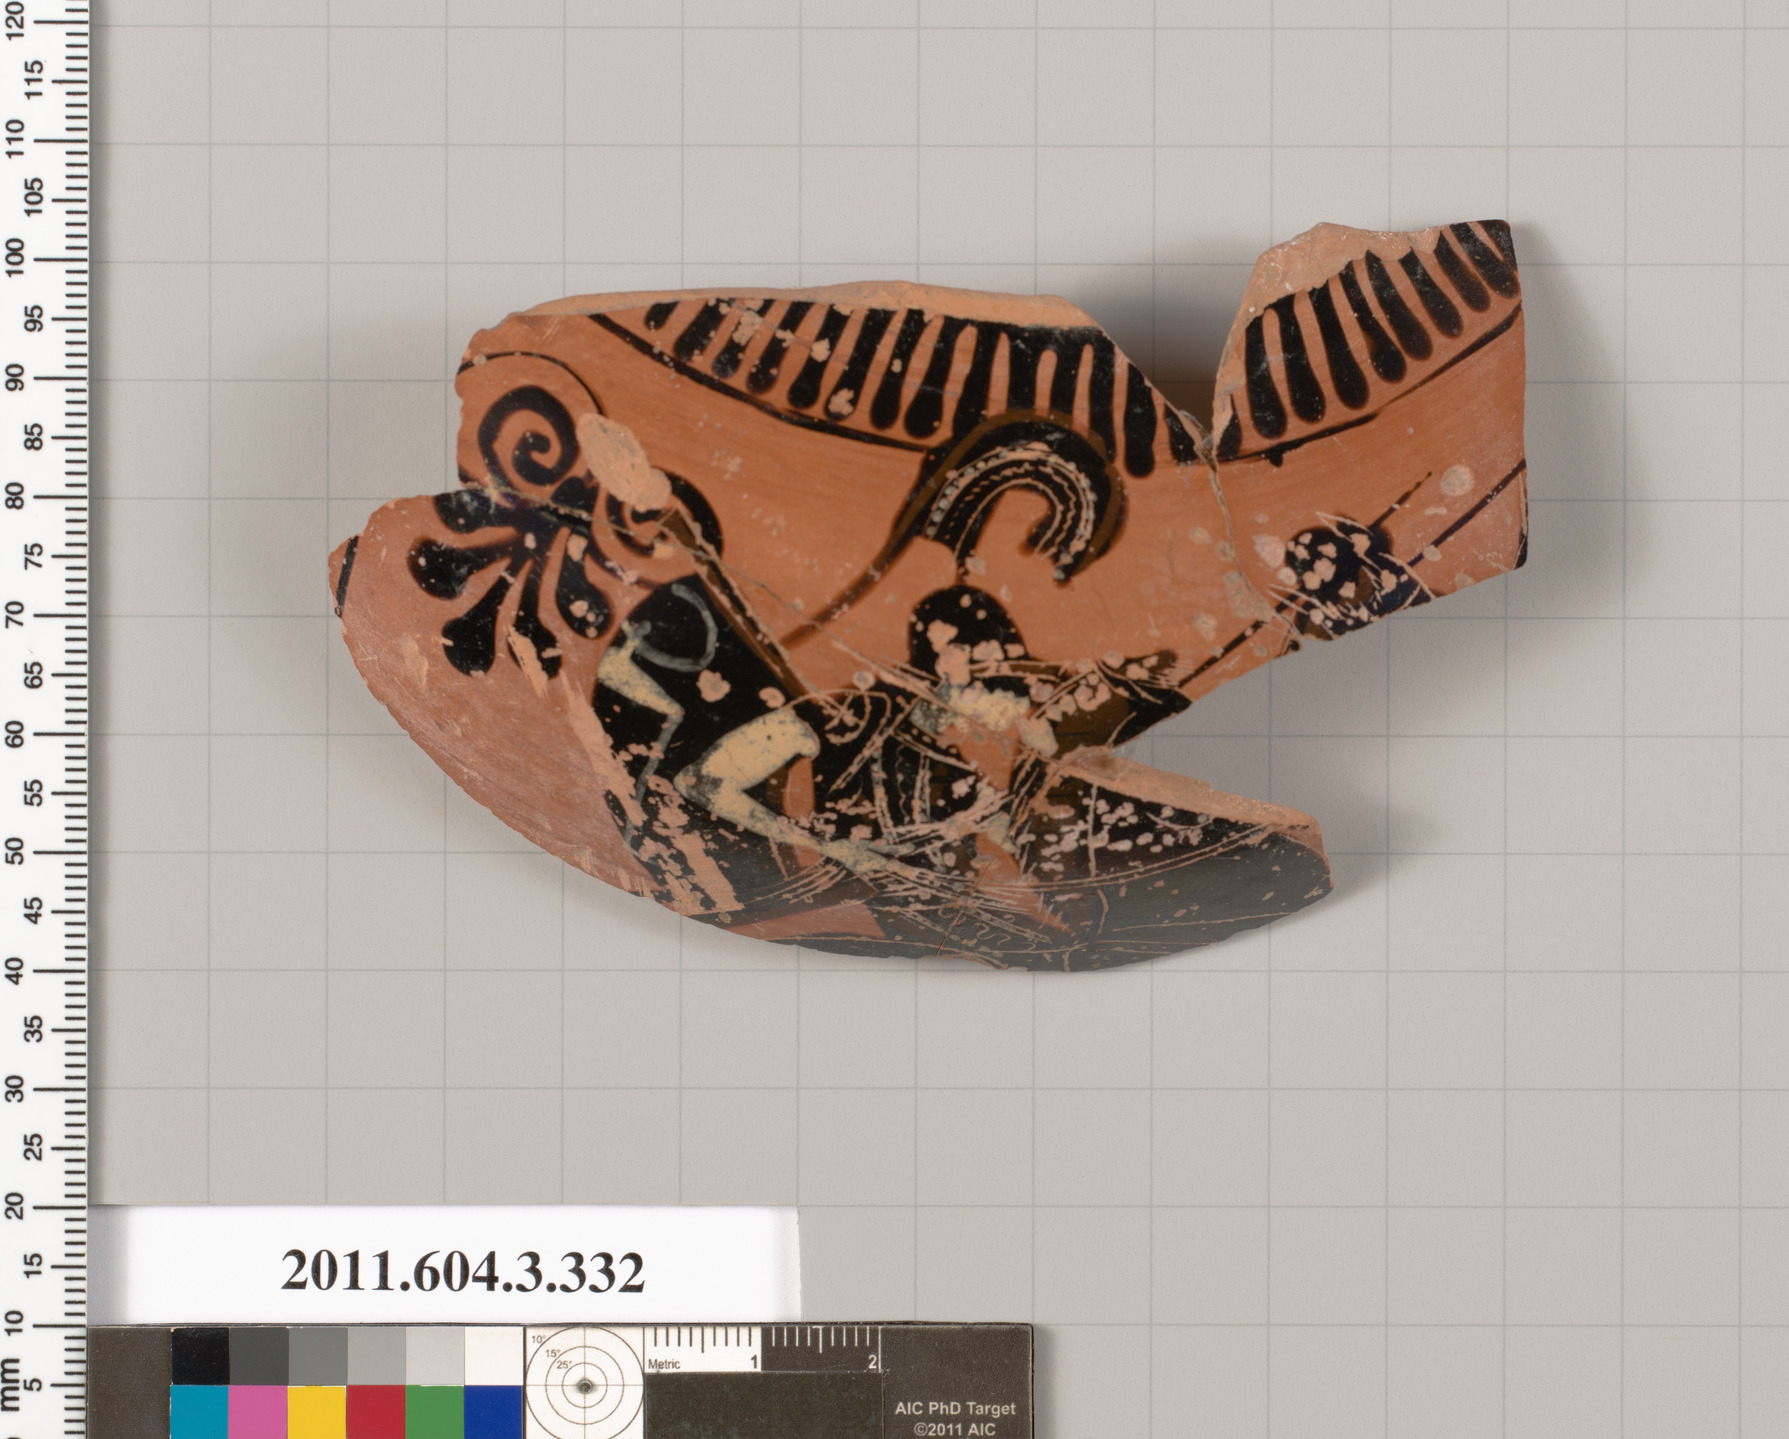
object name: neck amphora fragment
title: Terracotta fragment of a neck-amphora (jar)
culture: greek, attic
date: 500-468 BCE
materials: terracotta